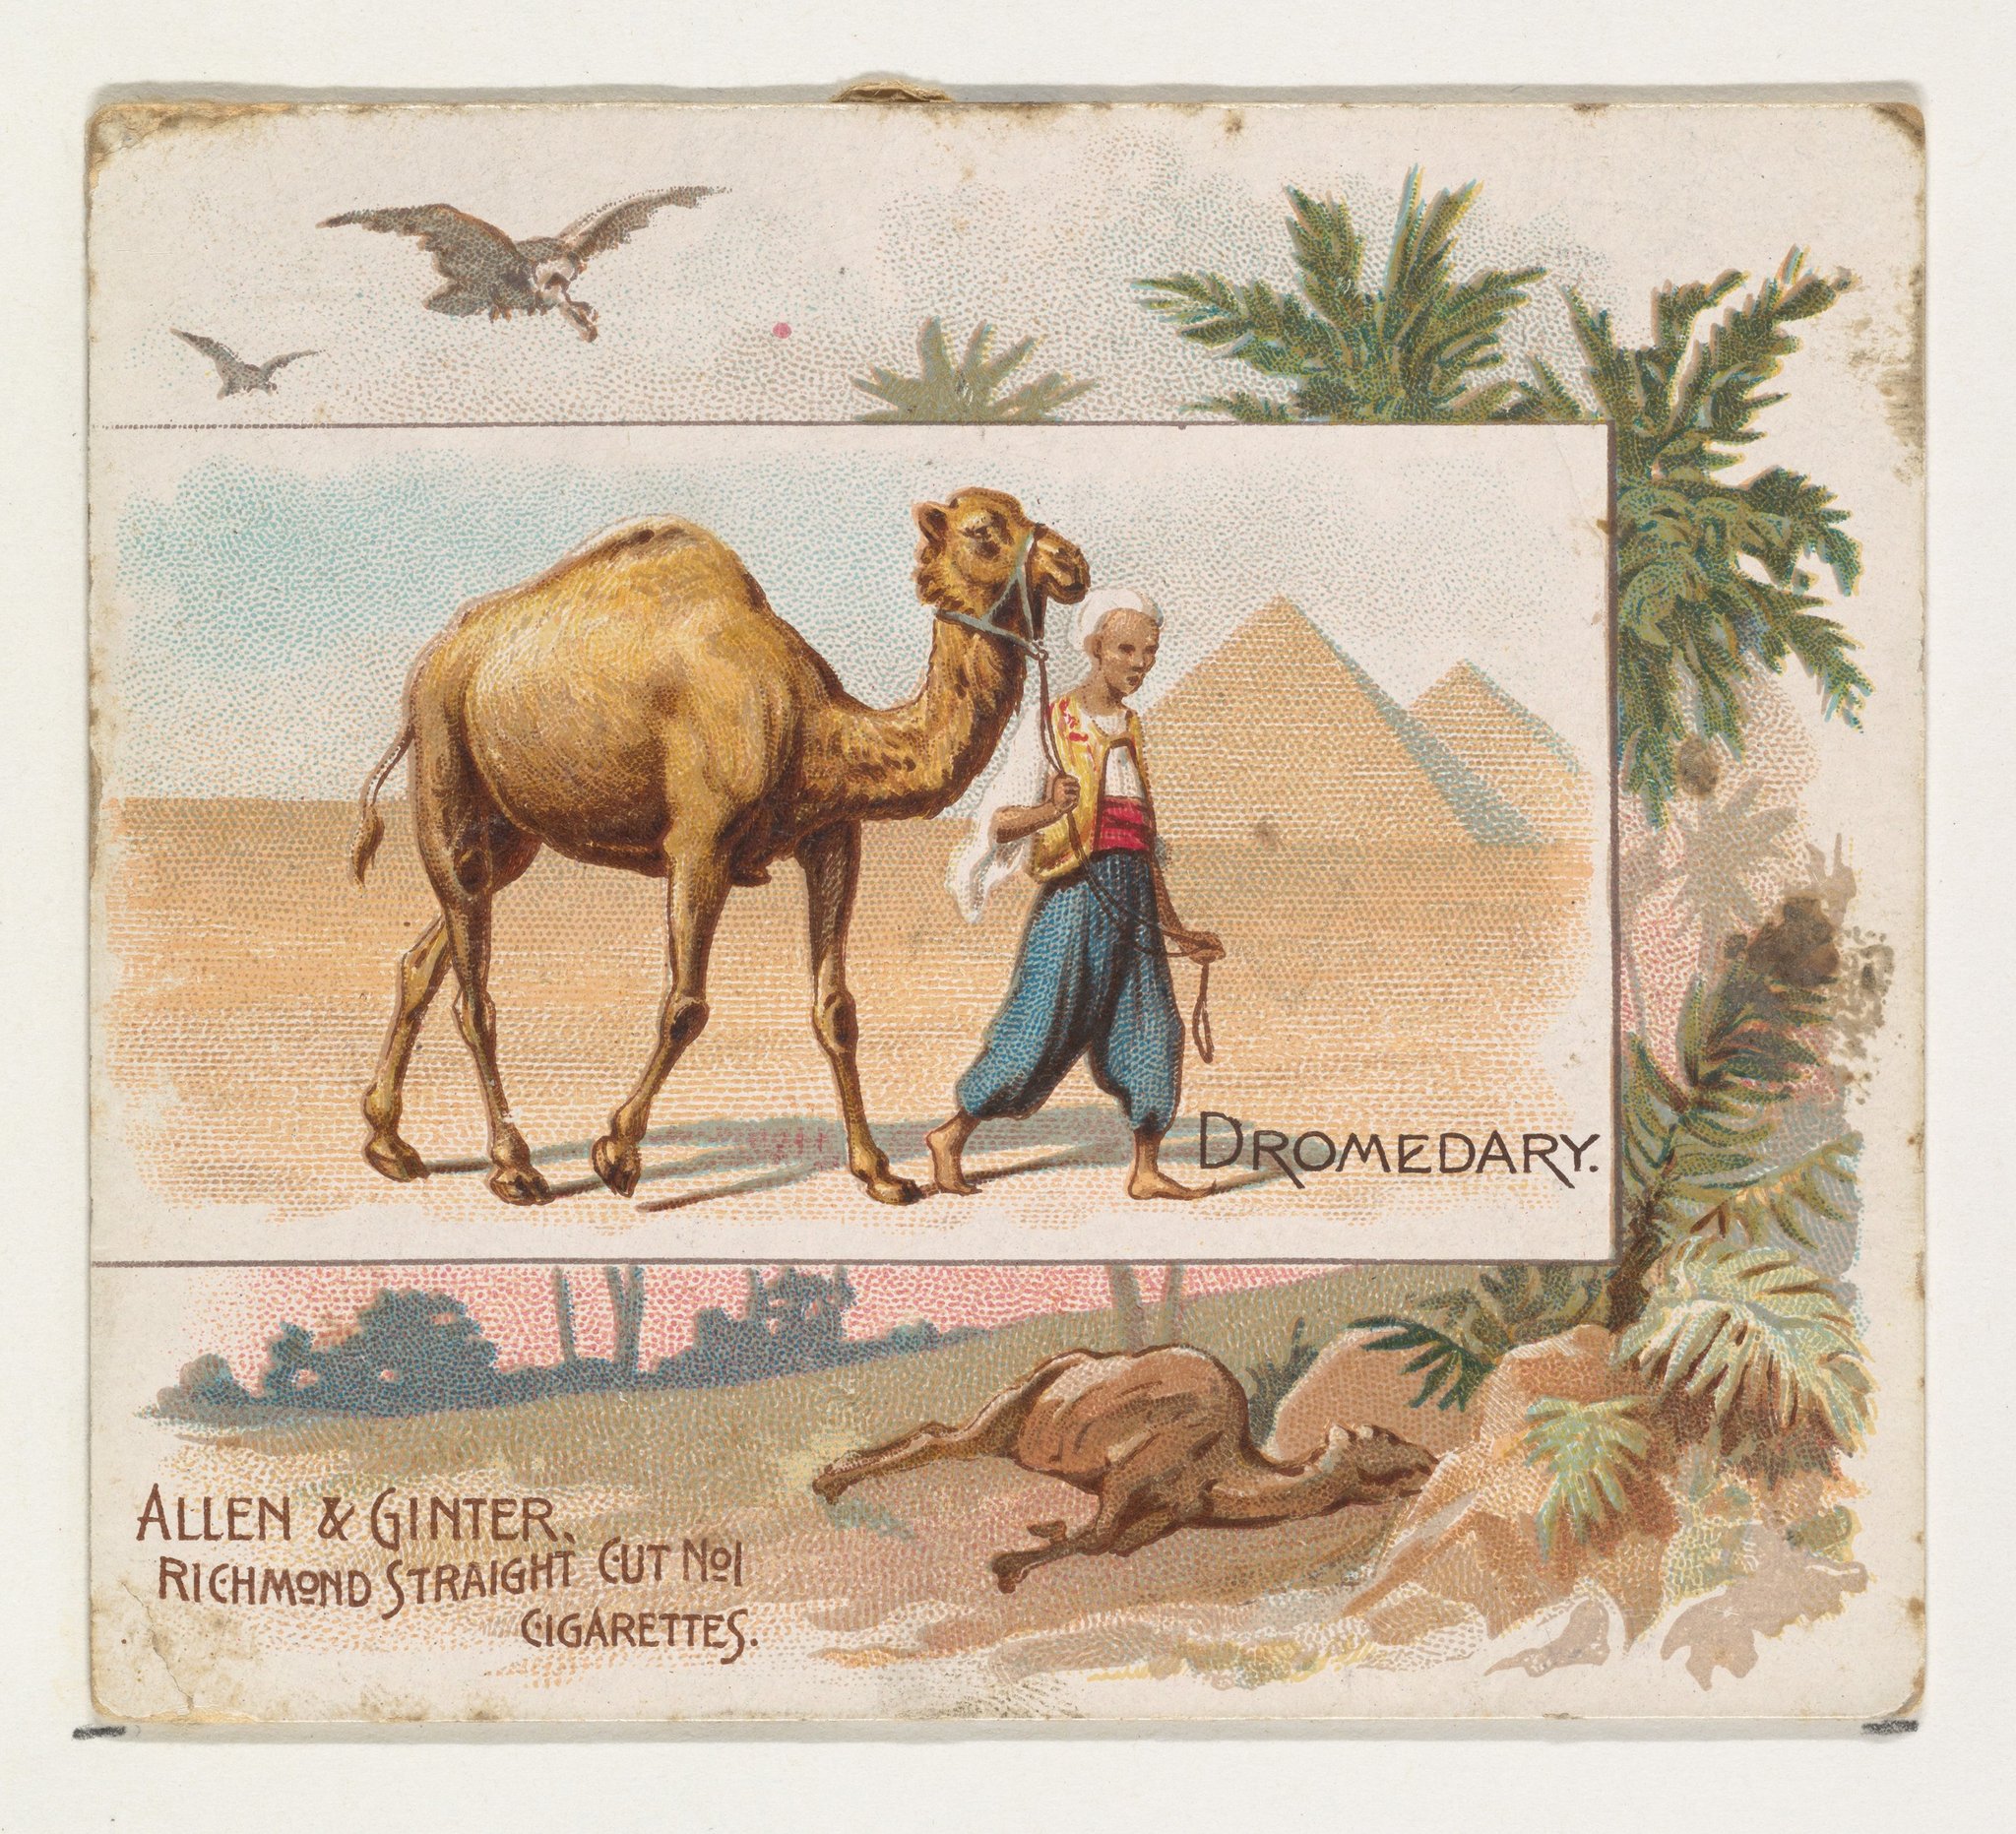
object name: print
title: Dromedary, from Quadrupeds series (N41) for Allen & Ginter Cigarettes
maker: allen & ginter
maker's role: publisher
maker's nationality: american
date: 1890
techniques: color lithograph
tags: camels